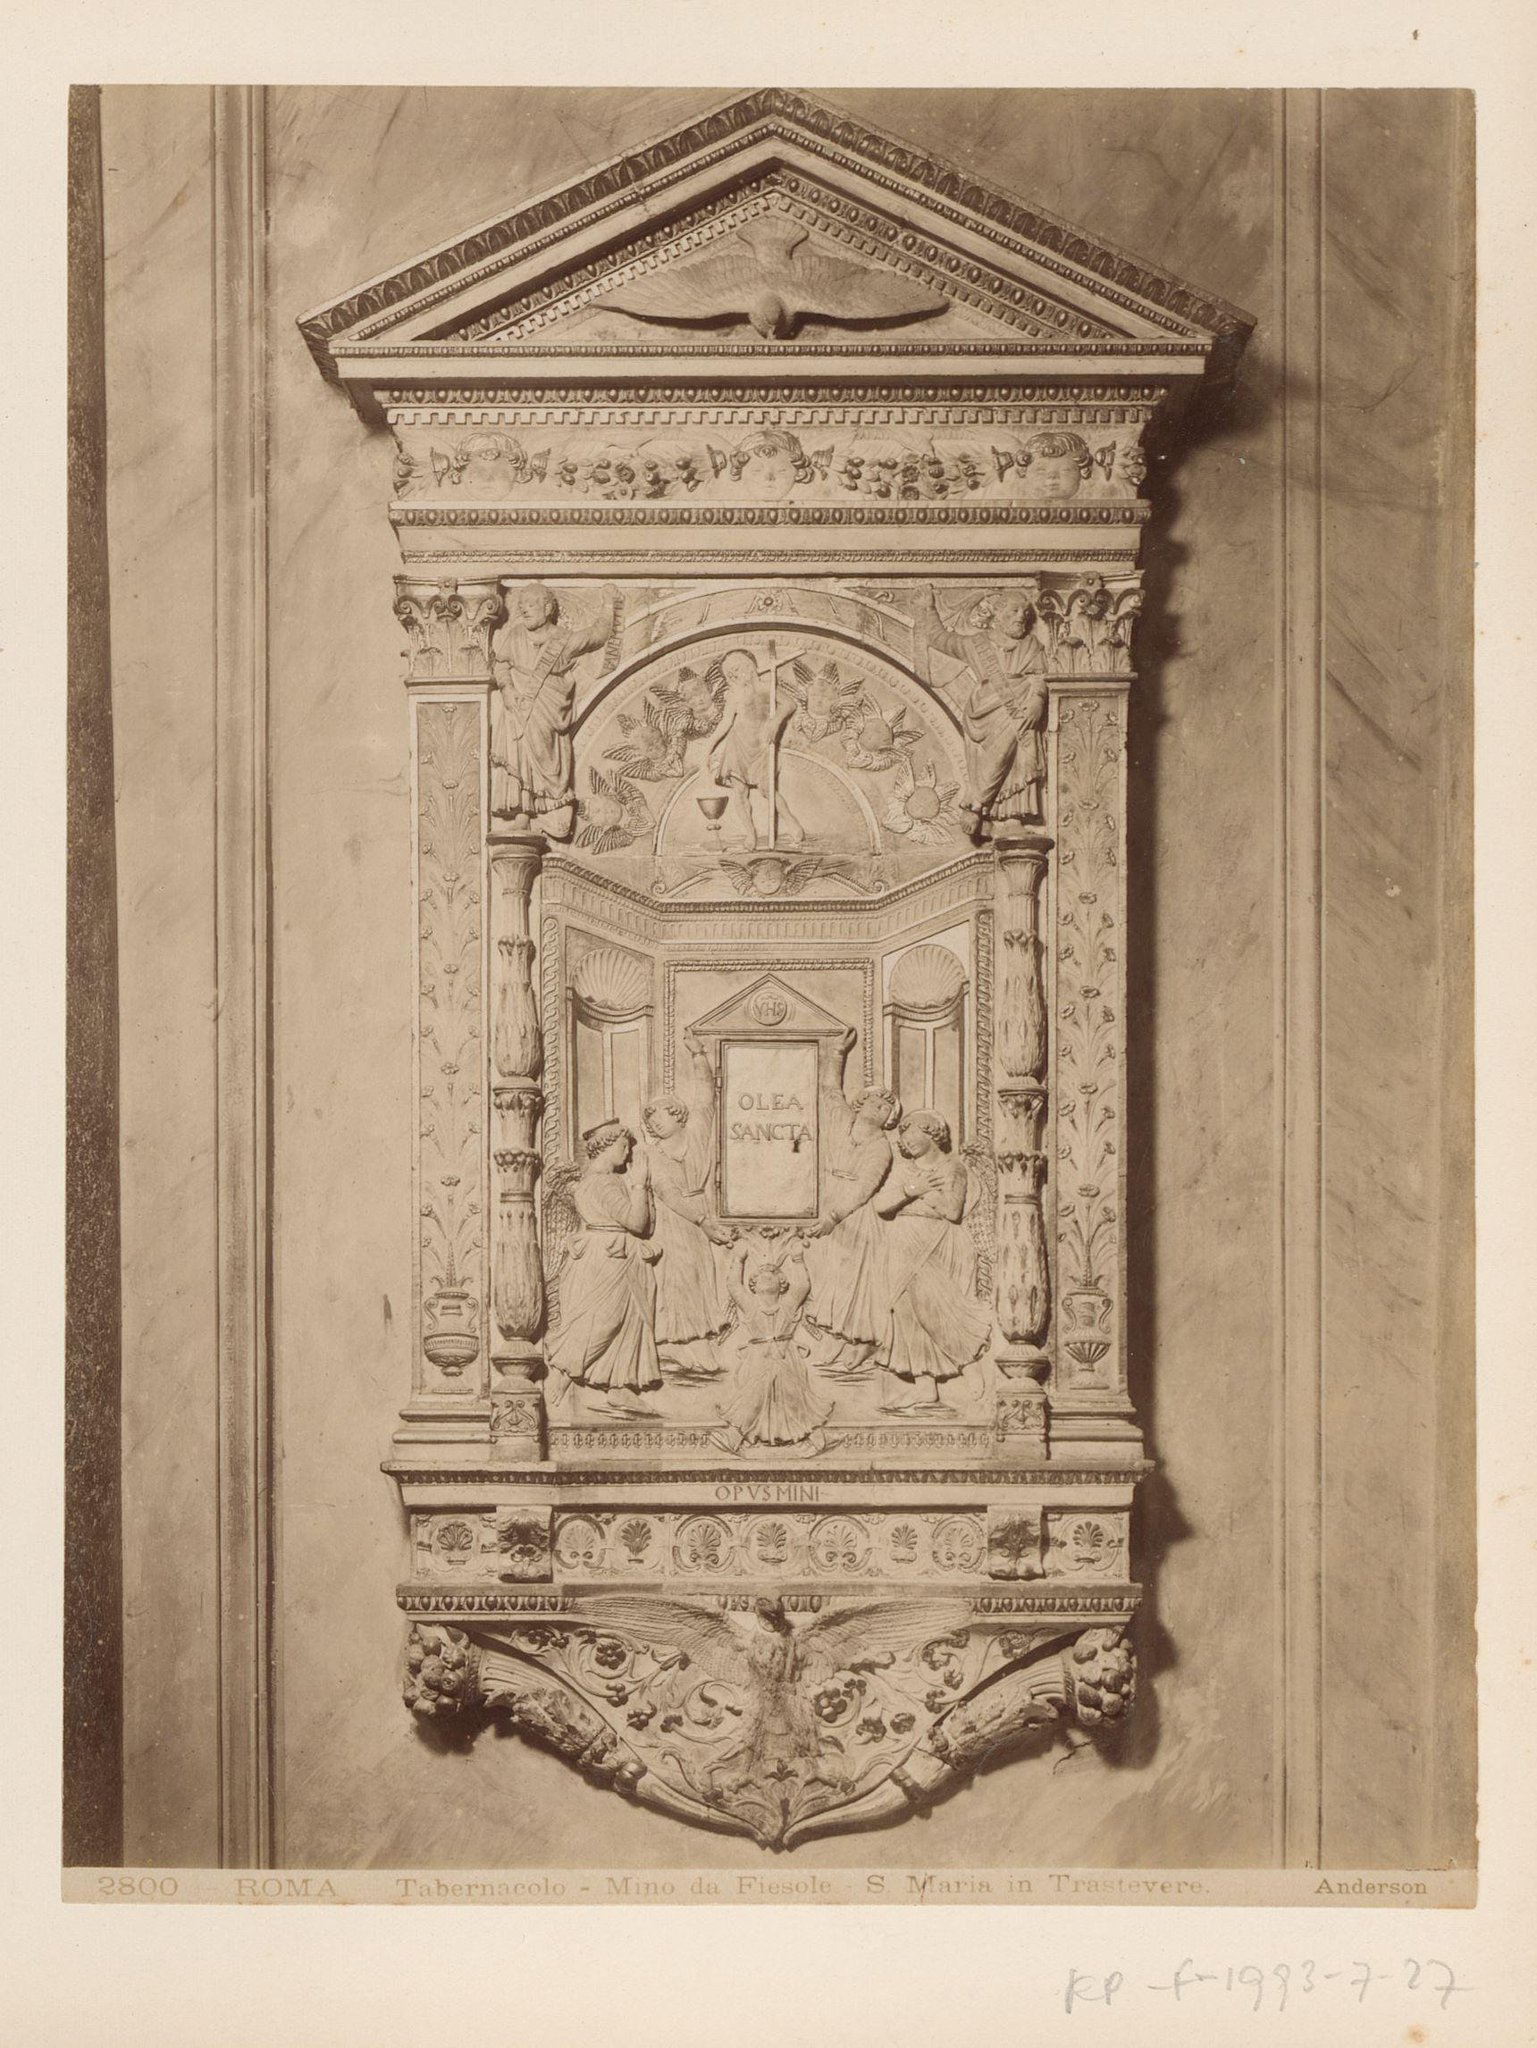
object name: album leaf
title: 2800 Roma Tabernacolo Mino da Fiesole. S. Maria in Trastevere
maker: james anderson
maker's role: fotograaf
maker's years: 1813-1877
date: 1857-1875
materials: paper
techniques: albumen print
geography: santa maria in trastevere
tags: tabernacle ~ altar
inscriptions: inscription: ‘2800 - ROMA - Tabernacolo - Mino da Fiesole - S. Mareia in Trastevere. Anderson’